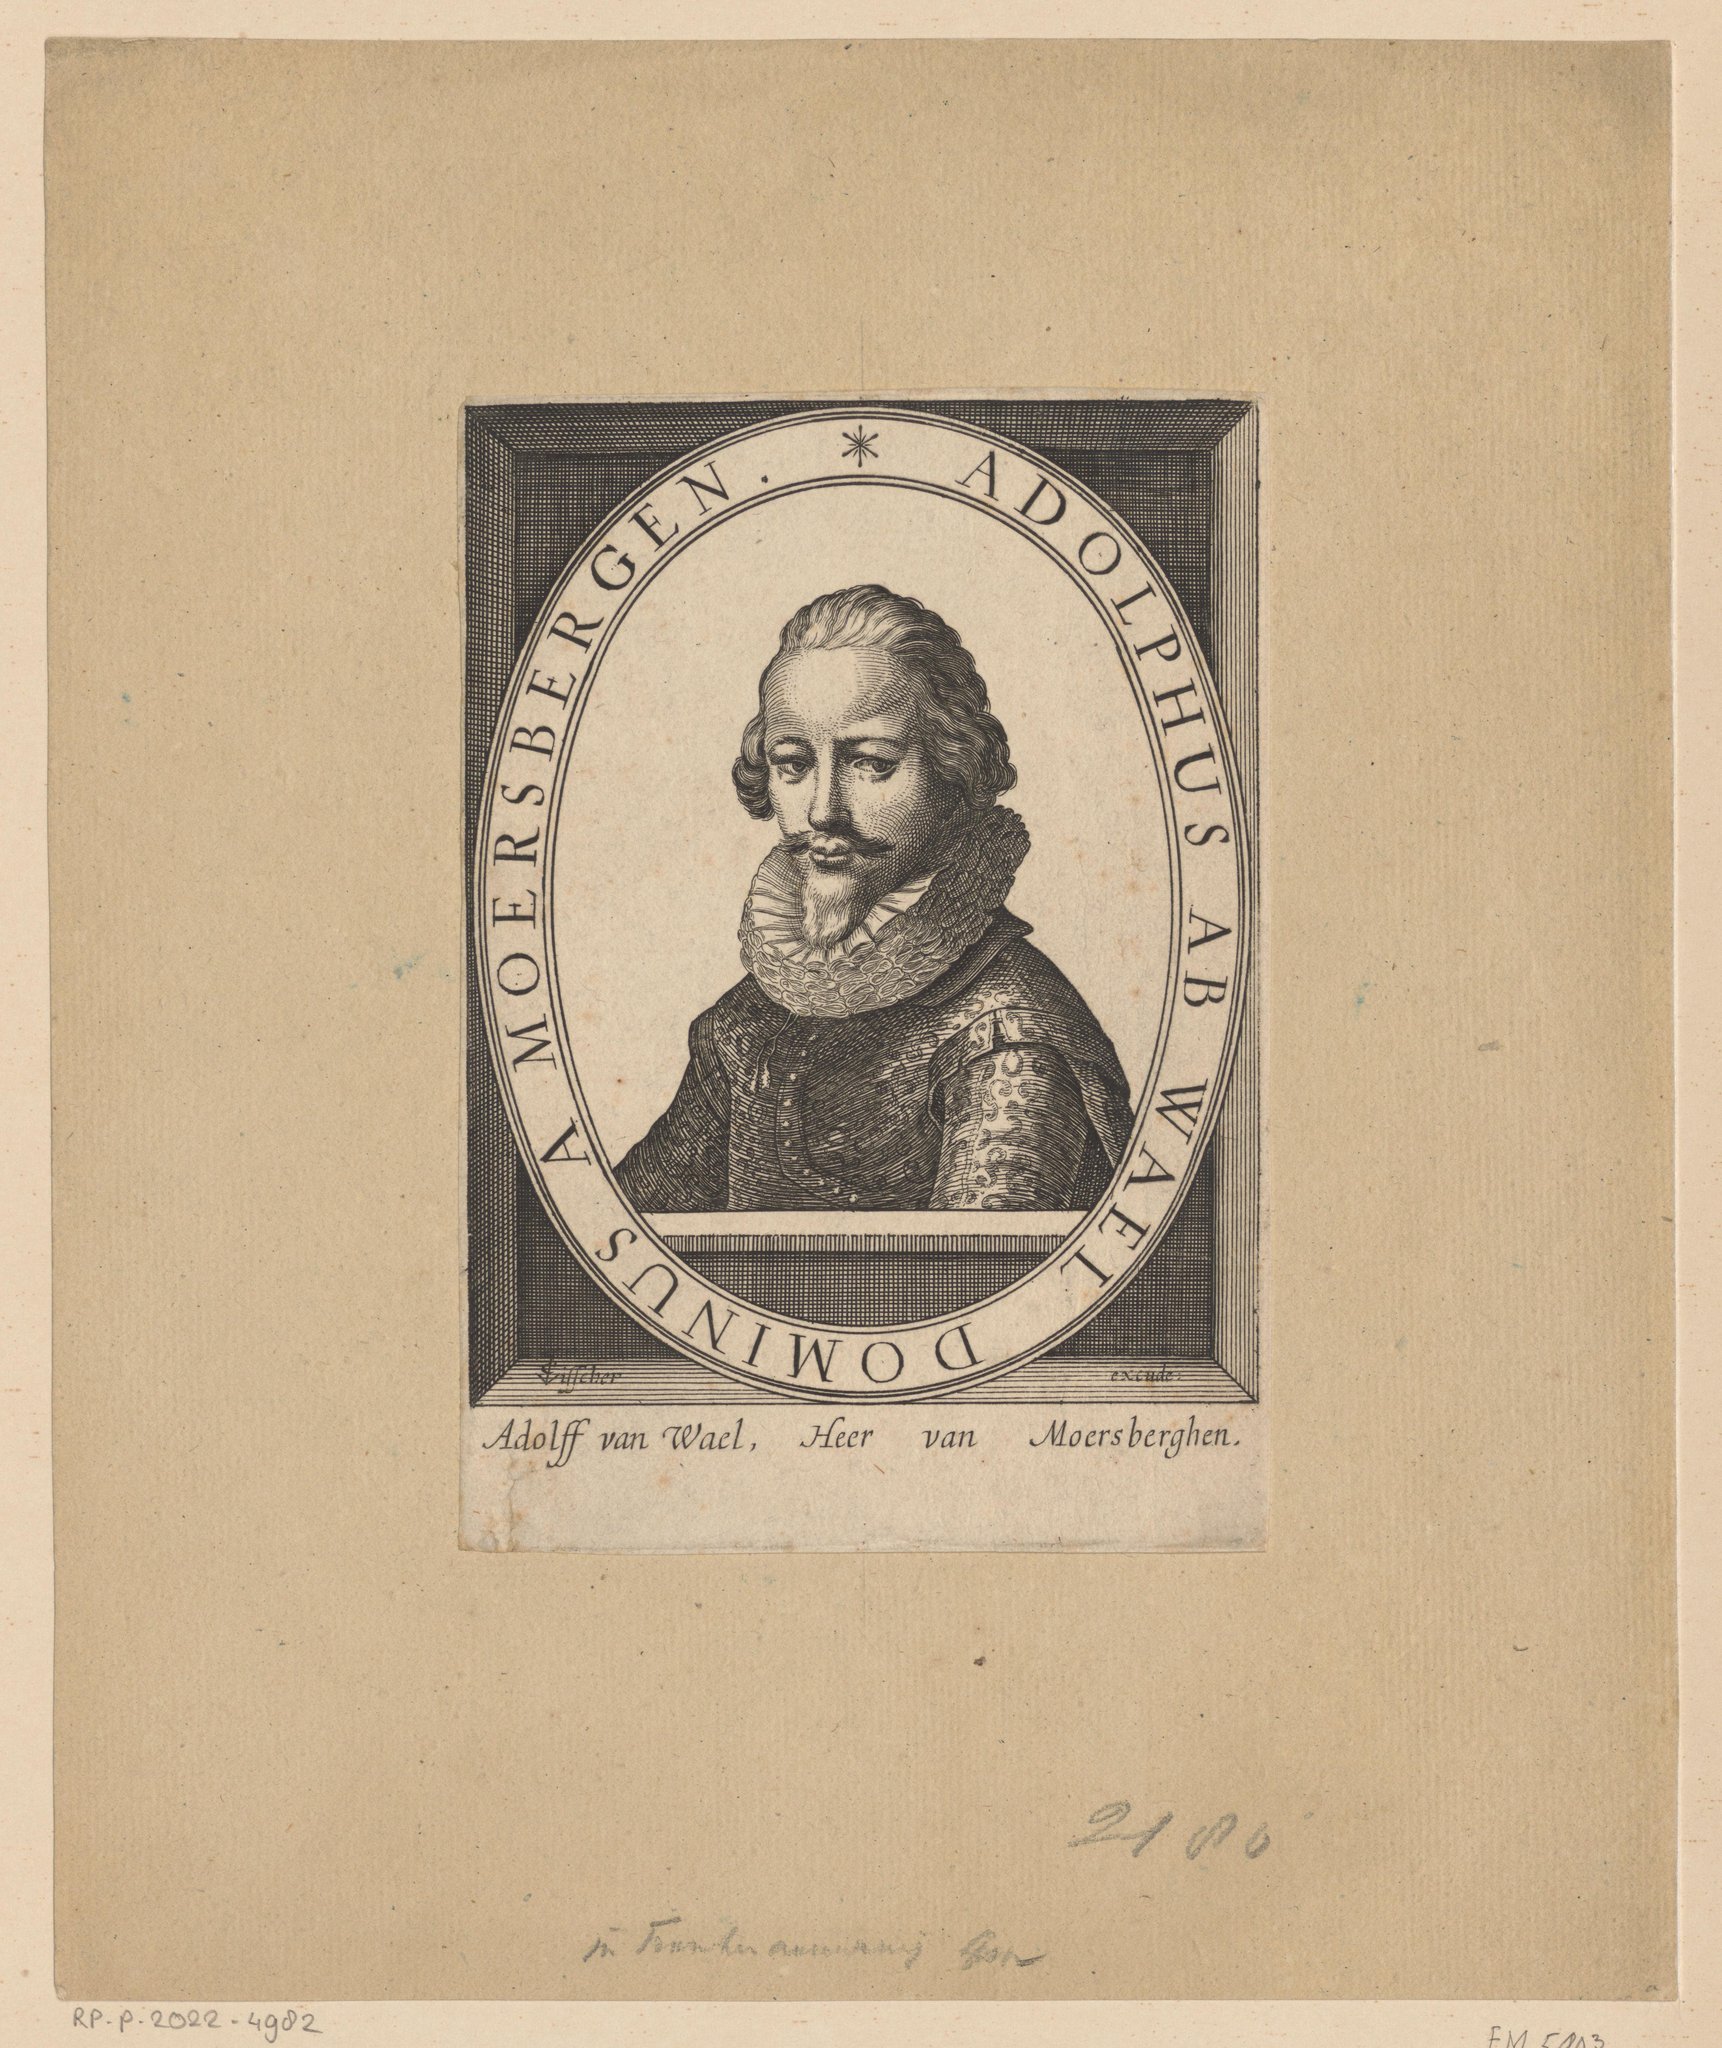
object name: print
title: Portret van Adolf de Wael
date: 1619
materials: paper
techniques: engraving, etching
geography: northern netherlands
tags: mayor, historical persons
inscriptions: collector's mark: Lugt 2228